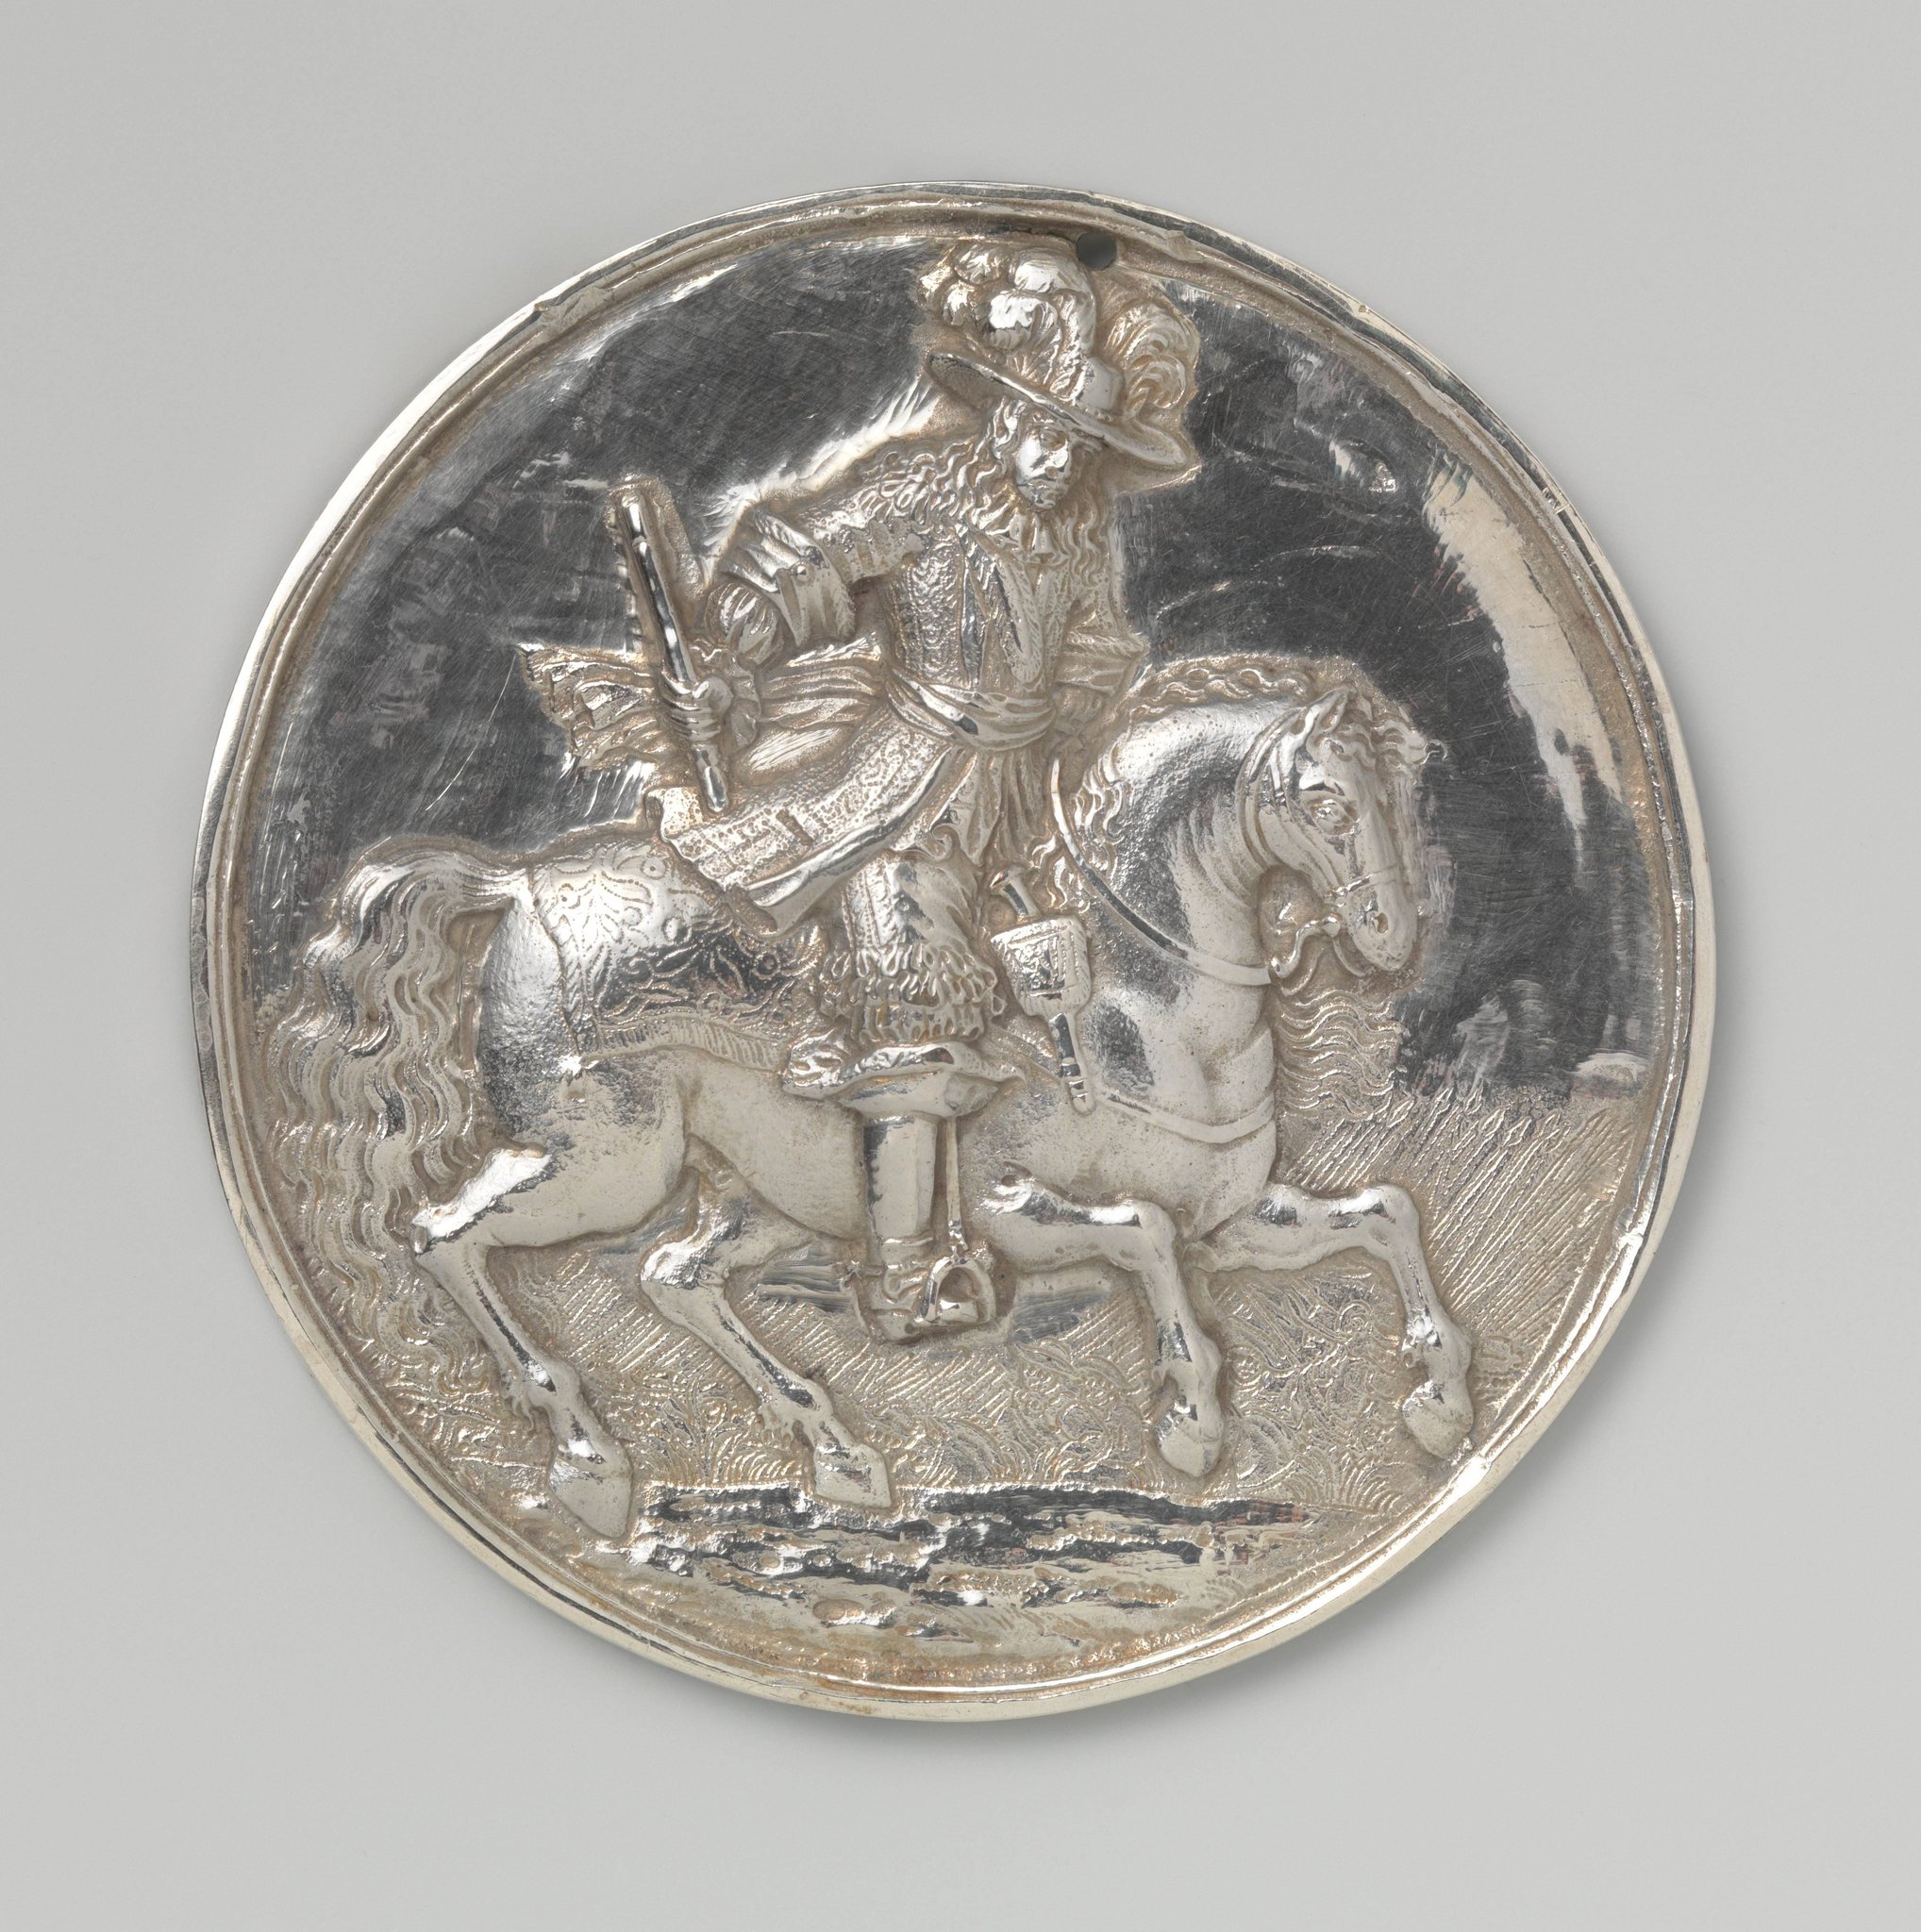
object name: history medal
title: Prince William III Appointed Commander-in-Chief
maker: wouter muller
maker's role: publisher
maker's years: 1604-1673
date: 1672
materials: silver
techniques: casting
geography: amsterdam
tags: the hague, william iii (prince of orange and king of england, scotland, and ireland)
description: Zilveren penning. Voorzijde: portret man te paard met commandostaf. Keerzijde: Faam blazend op twee loftrompetten onder wimpel met opschrift.